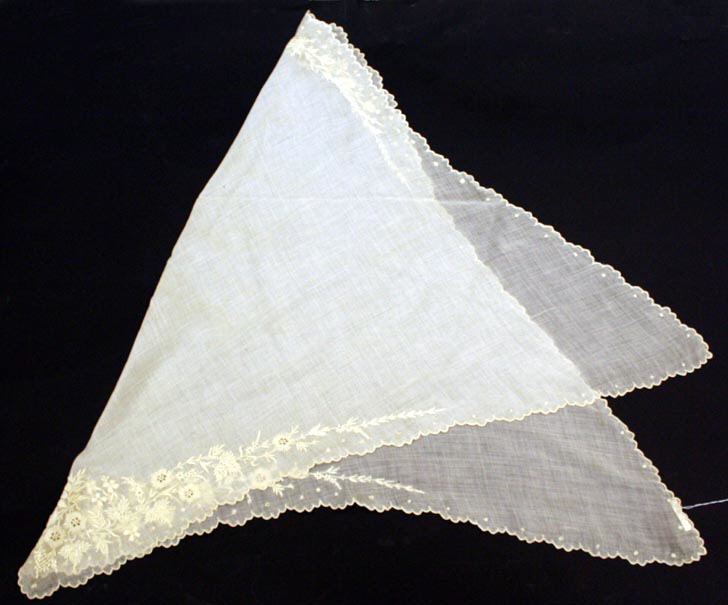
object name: kerchief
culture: american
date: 1834-1866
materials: cotton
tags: flowers